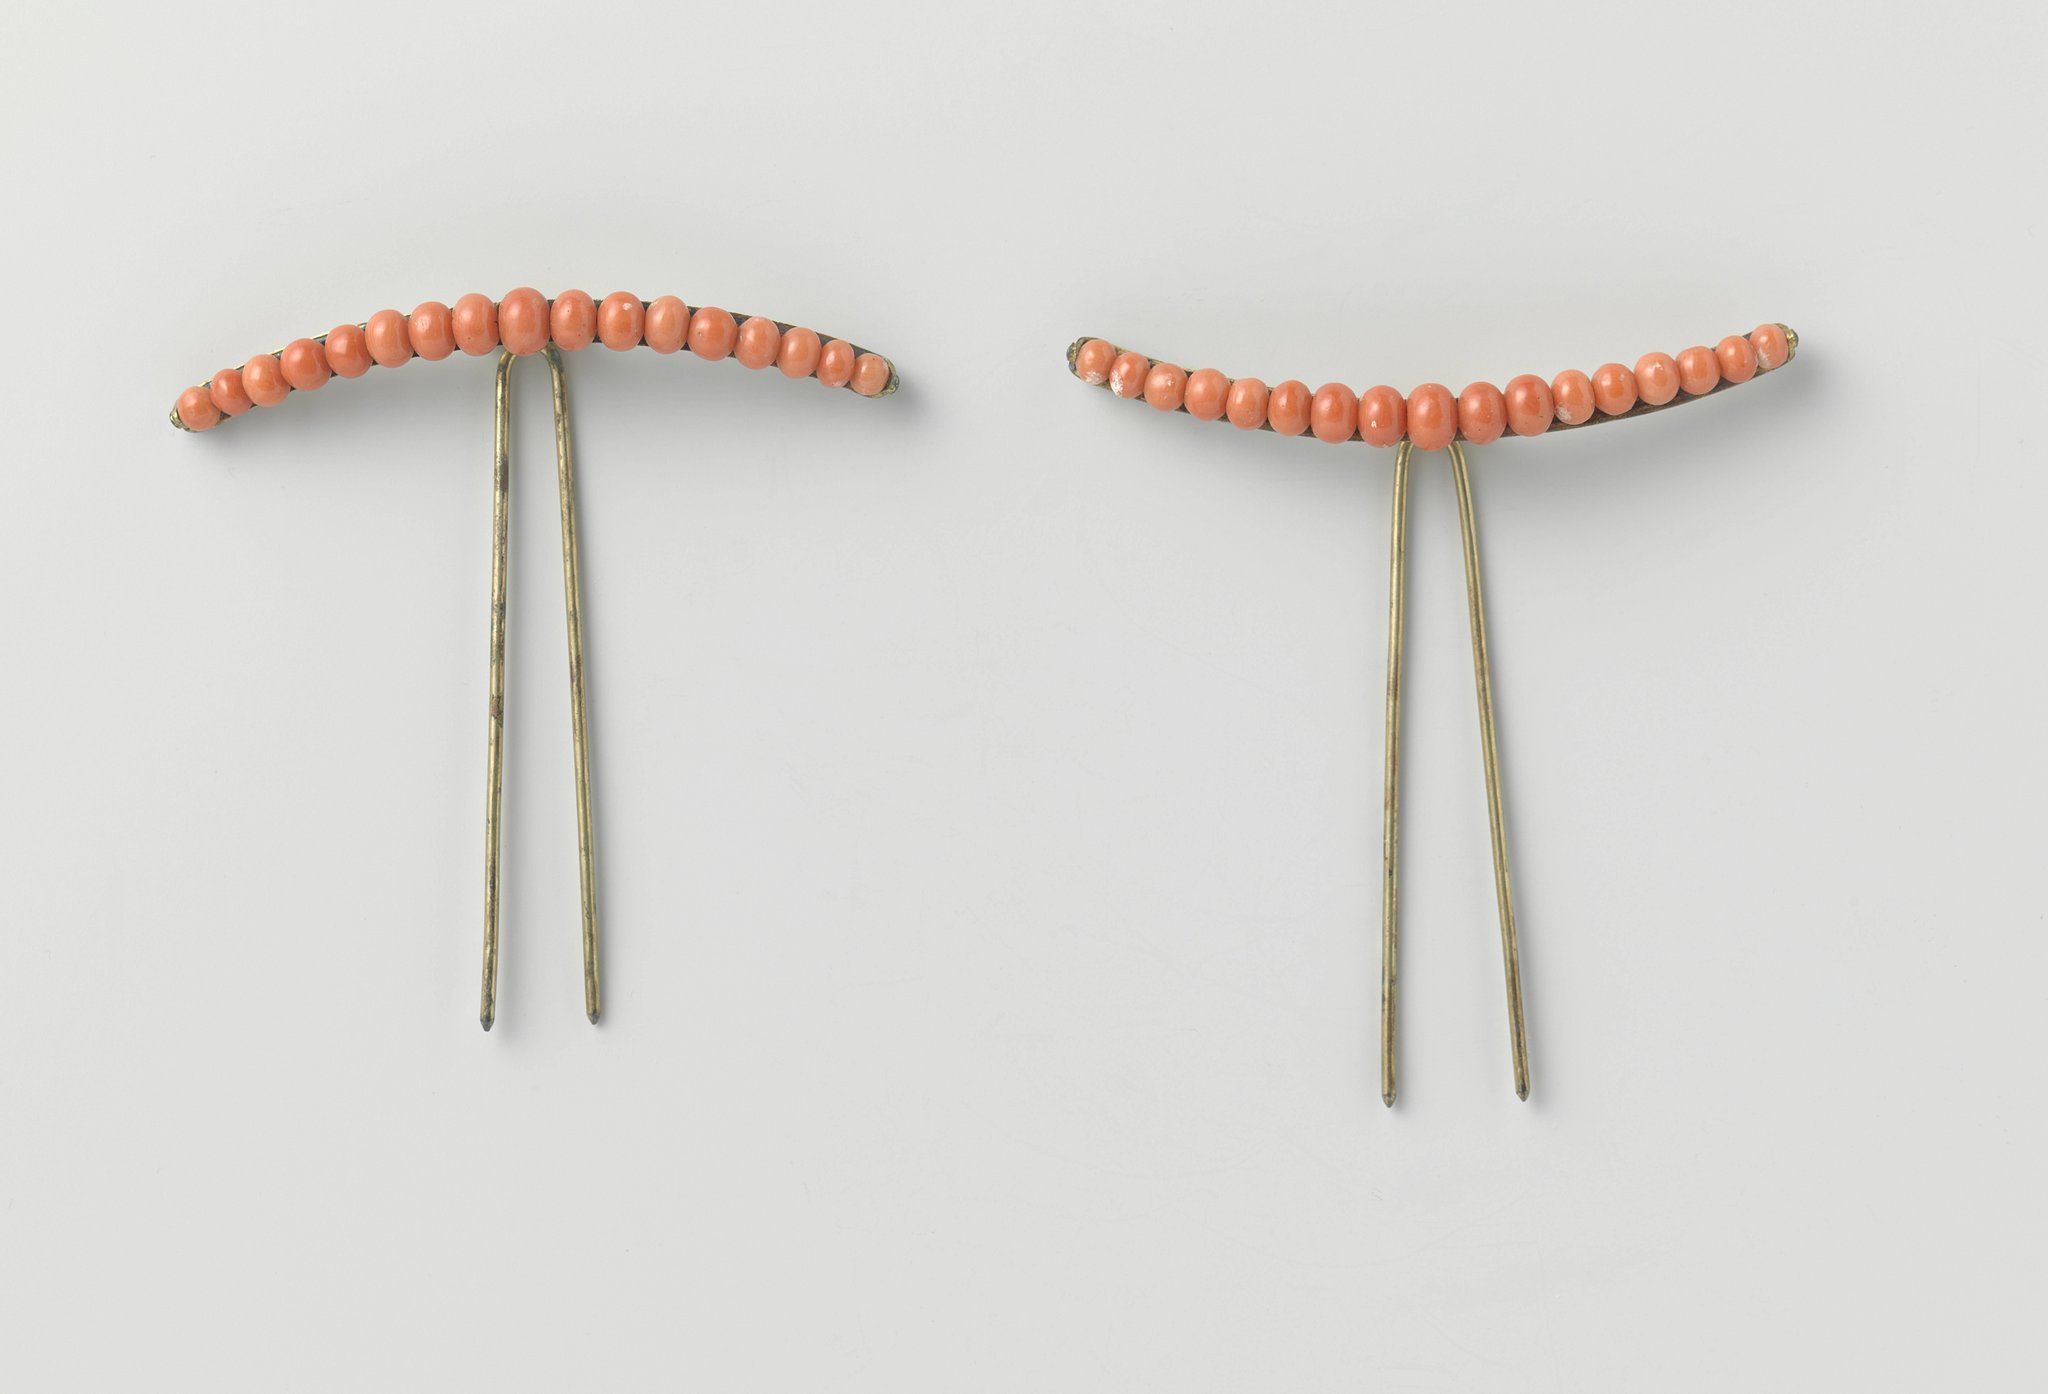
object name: comb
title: Haarkam met een gebogen rand waarop zeventien ronde bloedkoralen kralen en scharnierende, dubbele koperkleurige pen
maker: Anonymous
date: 1870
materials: copper, coral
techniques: sewing, forging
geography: netherlands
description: Haarkam bestaande uit een tweetandige metalen haarspeld, waarop een gebogen metalen band met zeventien bloedkoralen.